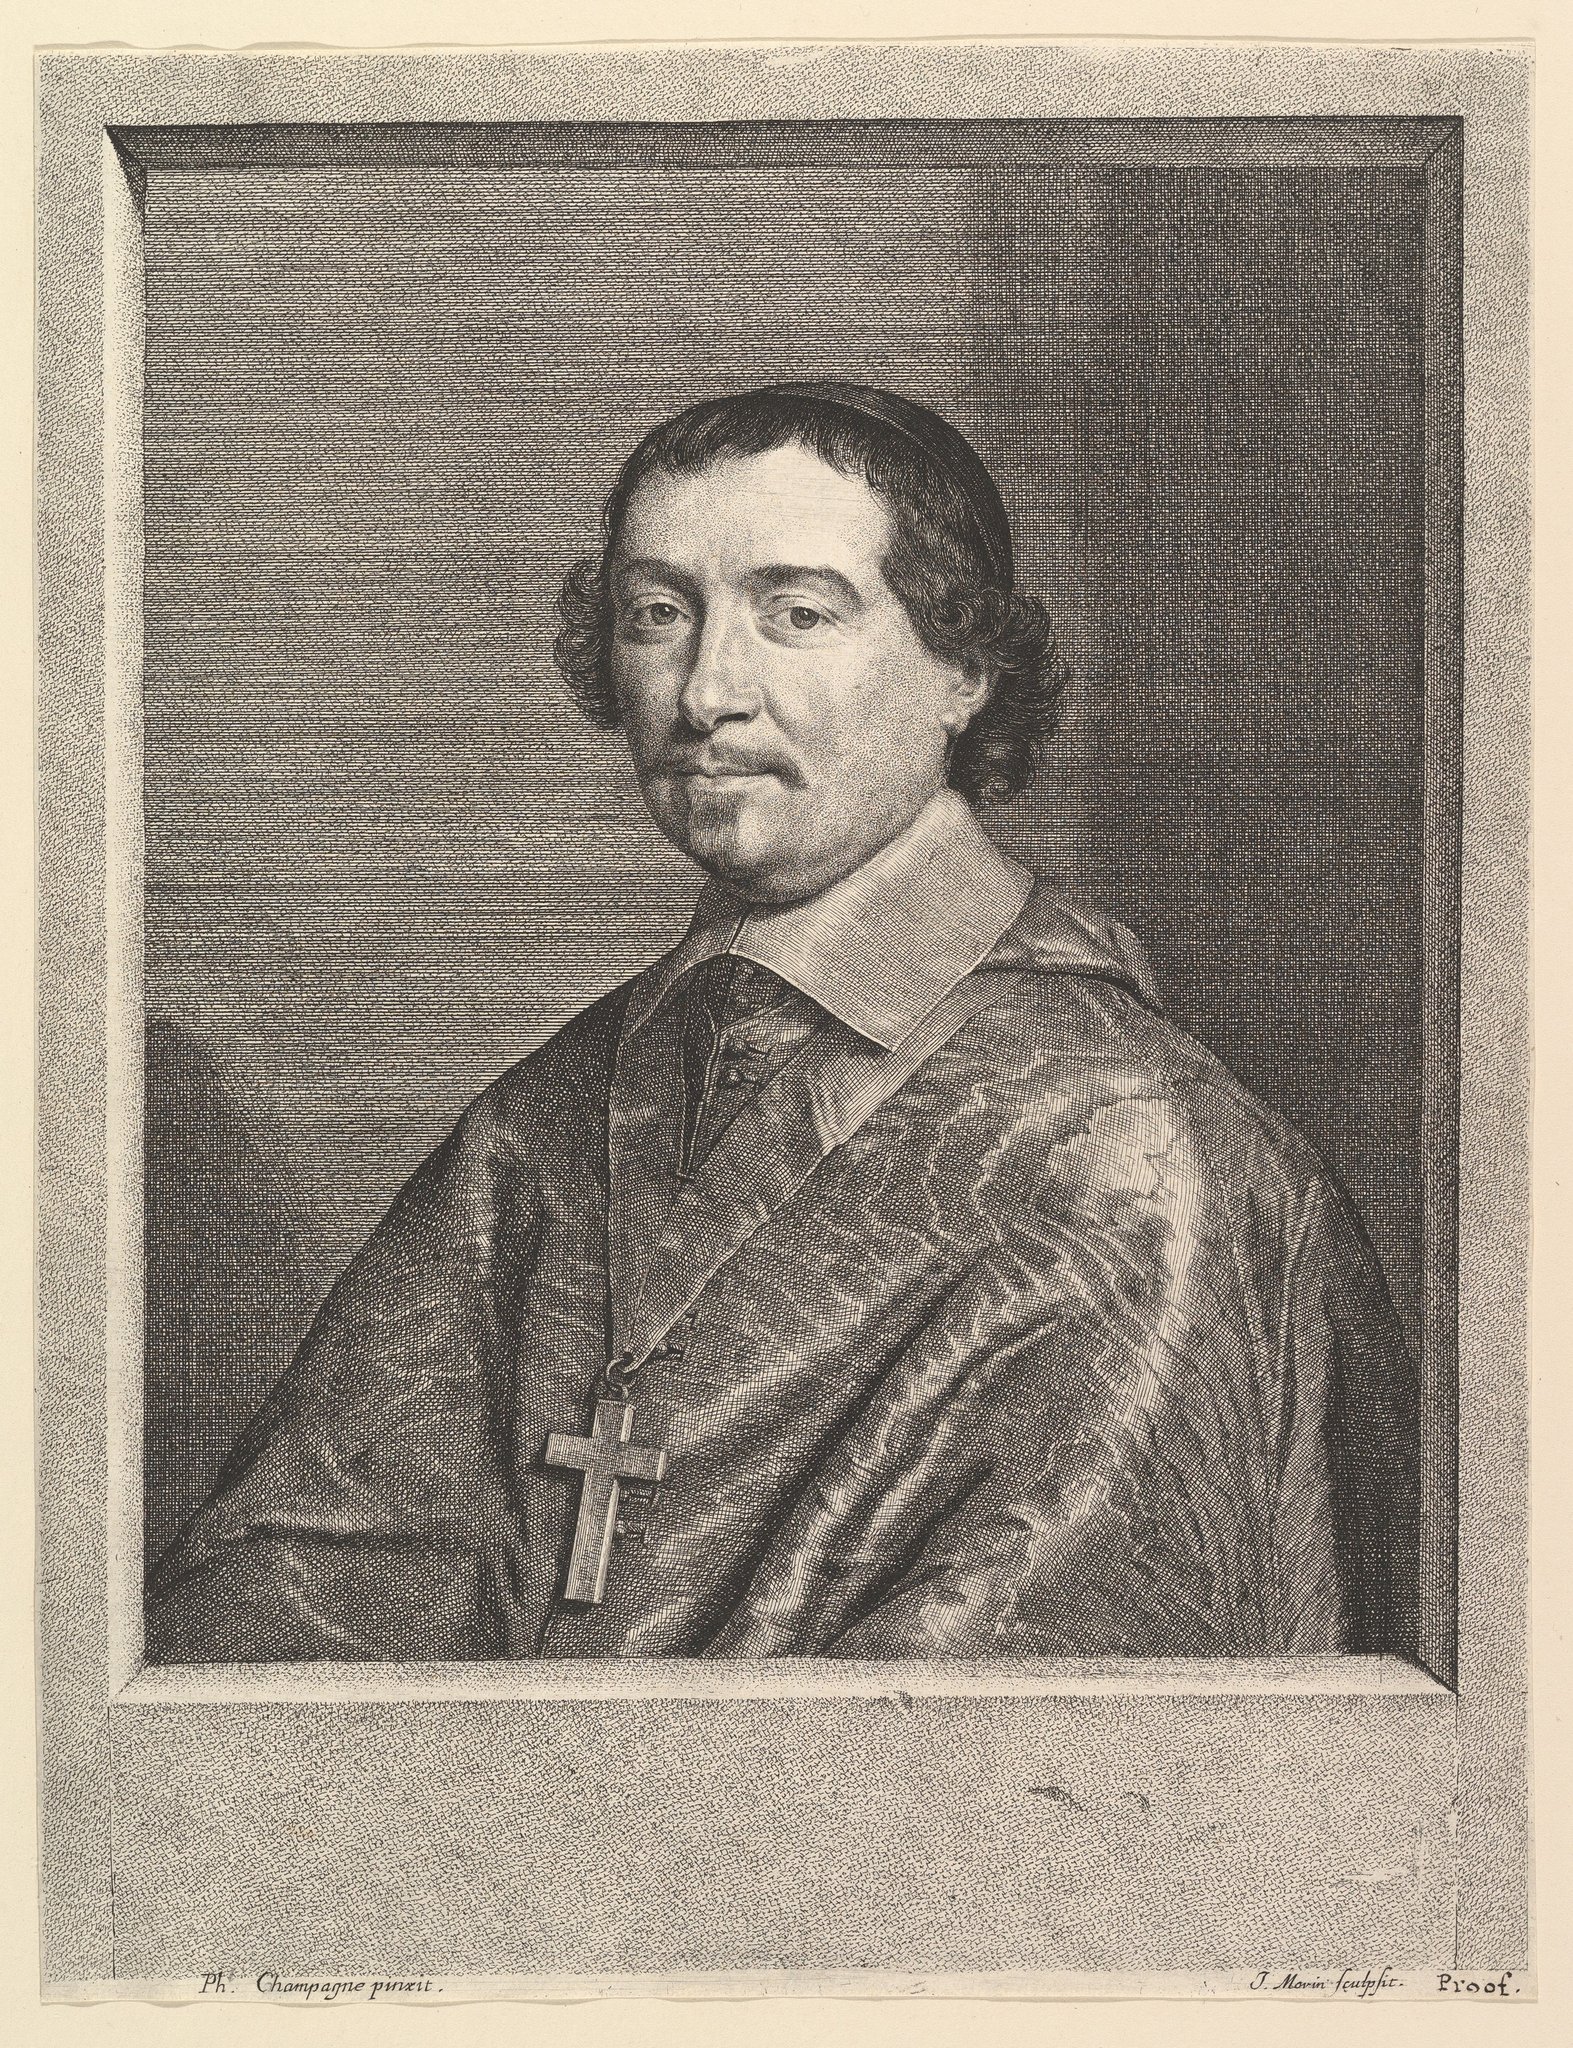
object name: print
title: Pierre Bartier, eveque de Montauban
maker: jean morin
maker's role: artist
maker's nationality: french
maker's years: 1605-1650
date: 1605-1650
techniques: etching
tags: men,portraits,cross